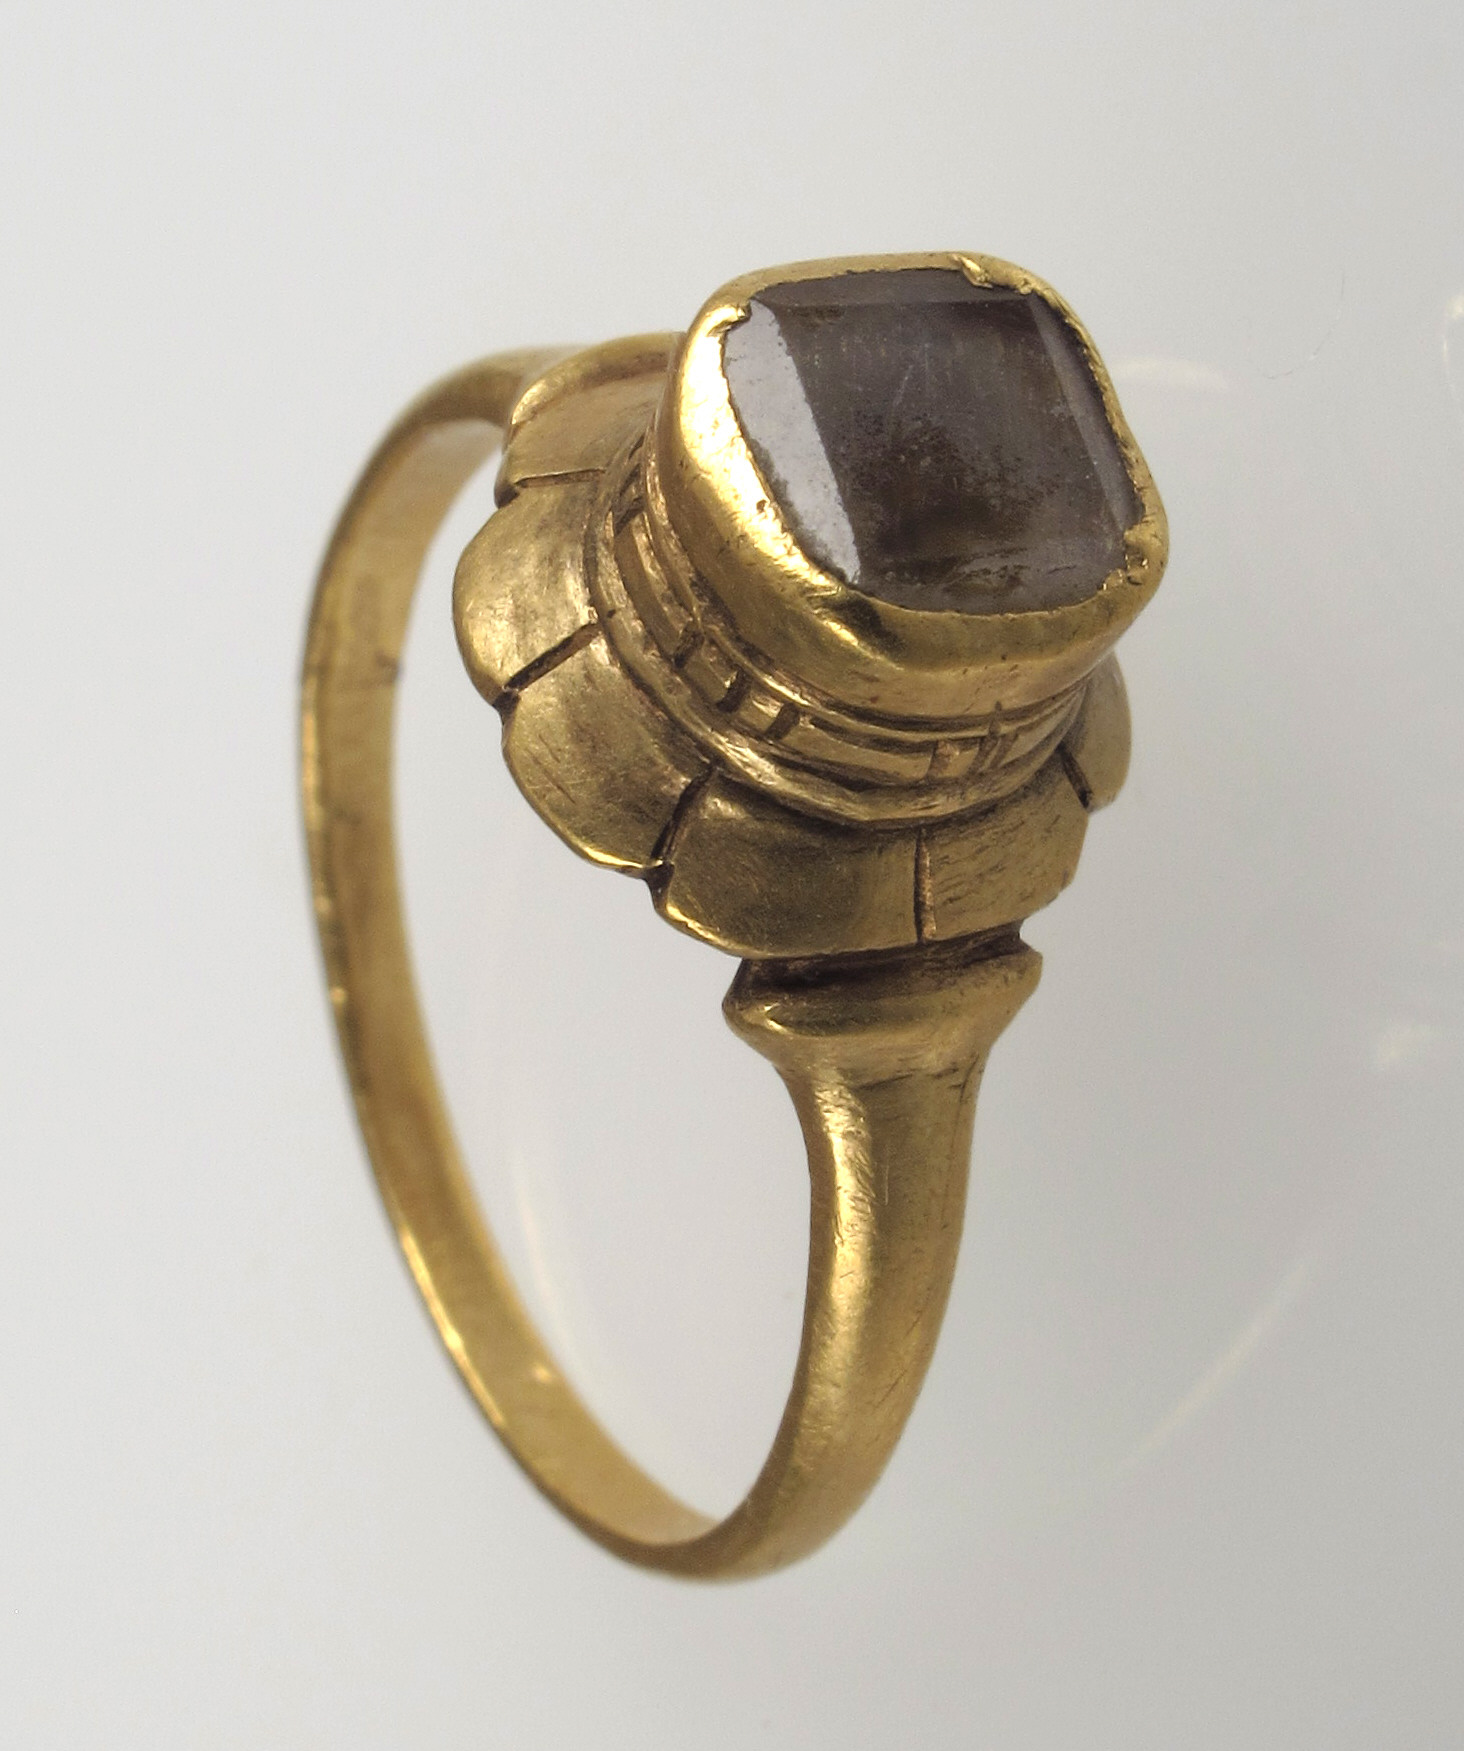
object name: ring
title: Finger Ring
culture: frankish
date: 501-1100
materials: glass, gold, paste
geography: northern france